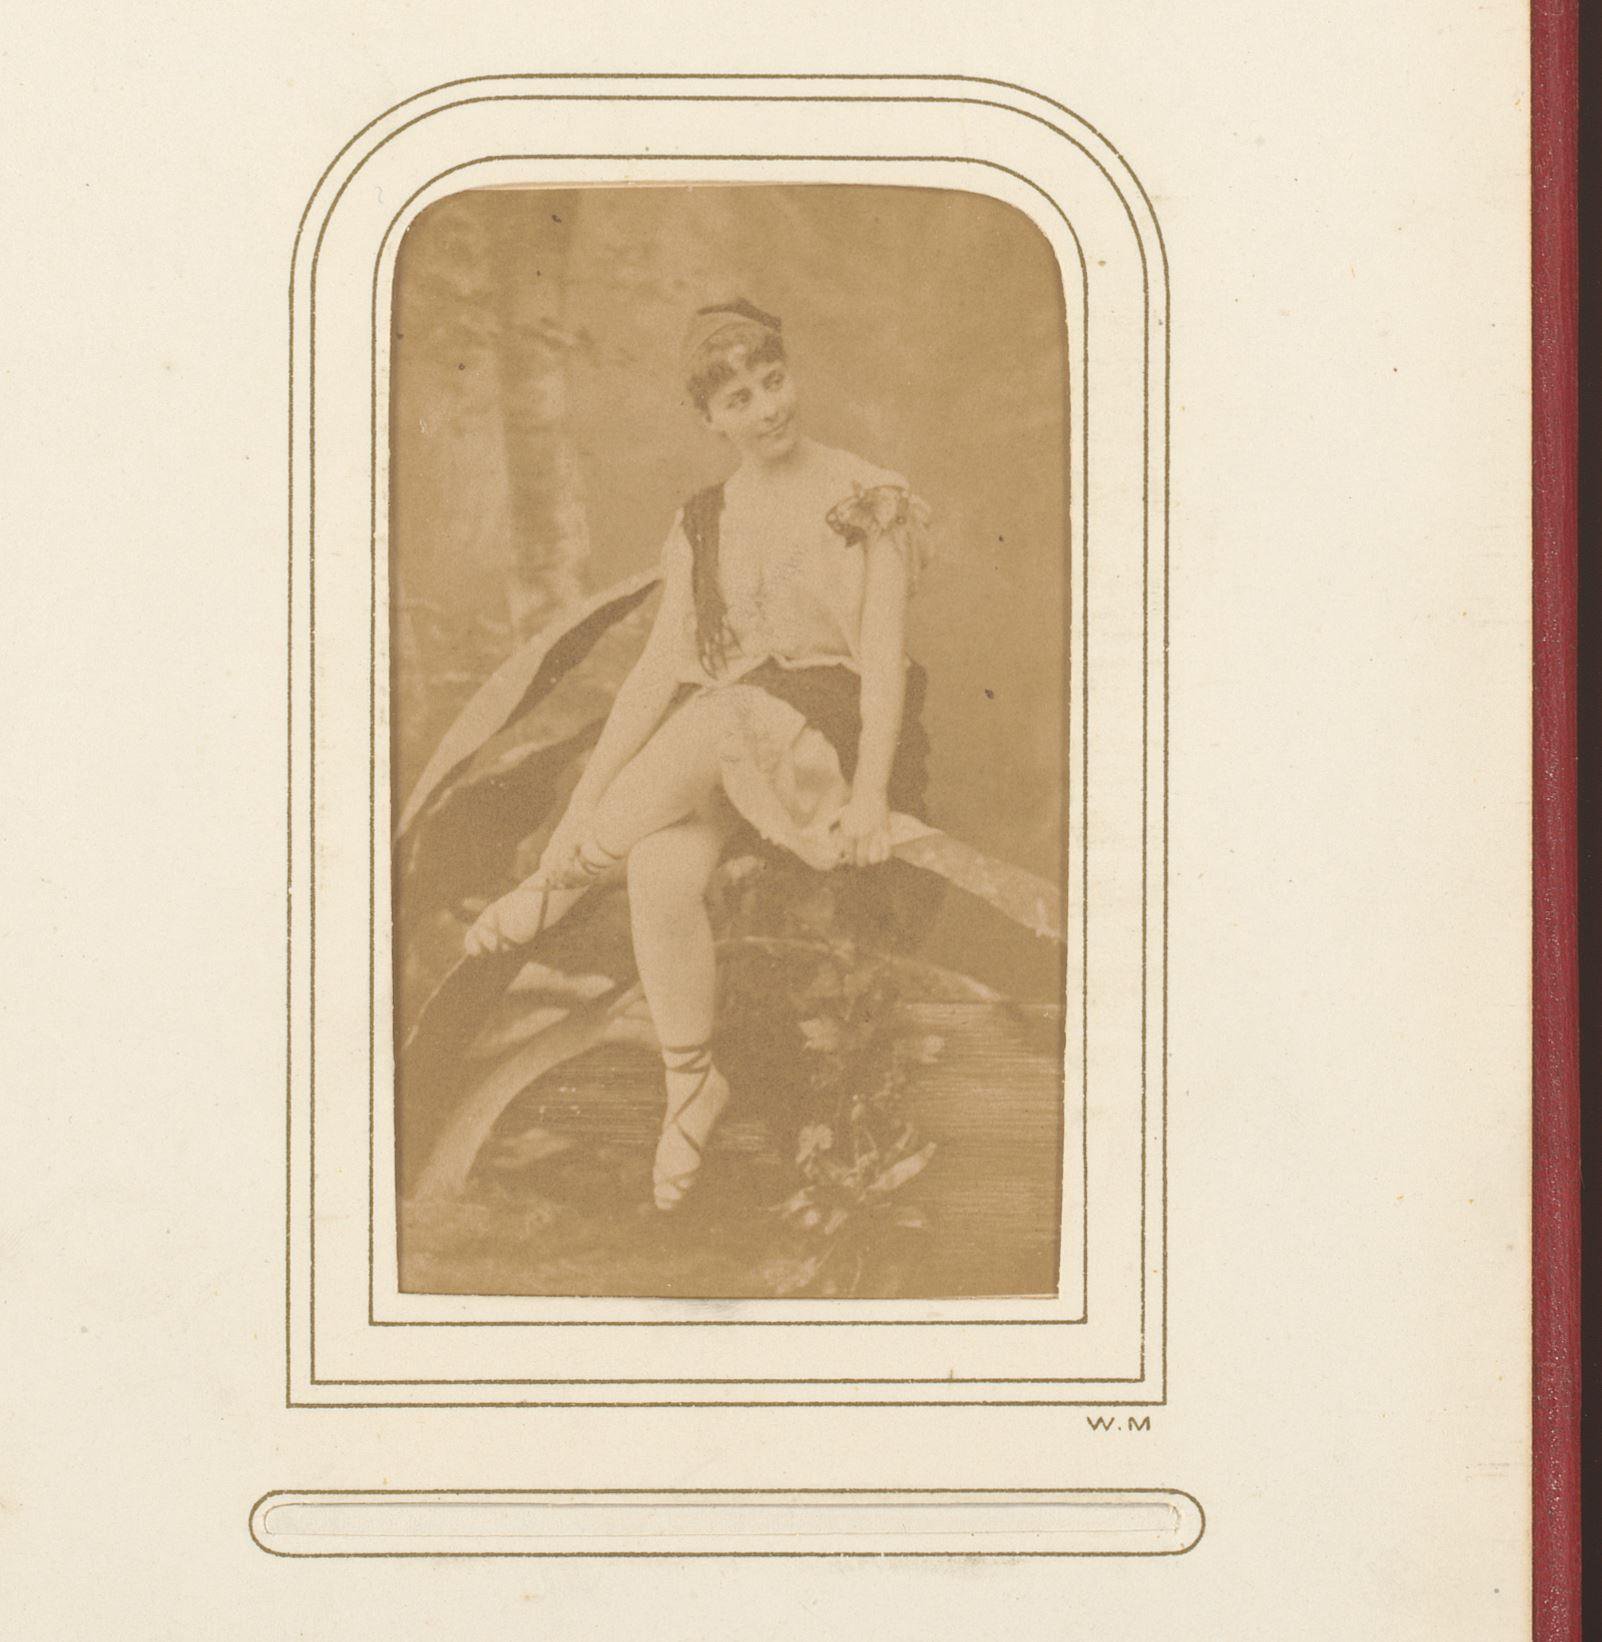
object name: album leaf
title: Portret van Ellen Hartman, zittend in decor met rivier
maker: Anonymous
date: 1880-1890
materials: cardboard, photographic support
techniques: albumen print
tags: historical persons - bb - woman, portrait of actor, actress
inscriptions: annotation: ‘Fru Hartman som/ Puck i midsommar/ nattsdröm’, annotation: ‘1860 - 1945/ b hedlund/ gift v. B[..]on/ Cederström’